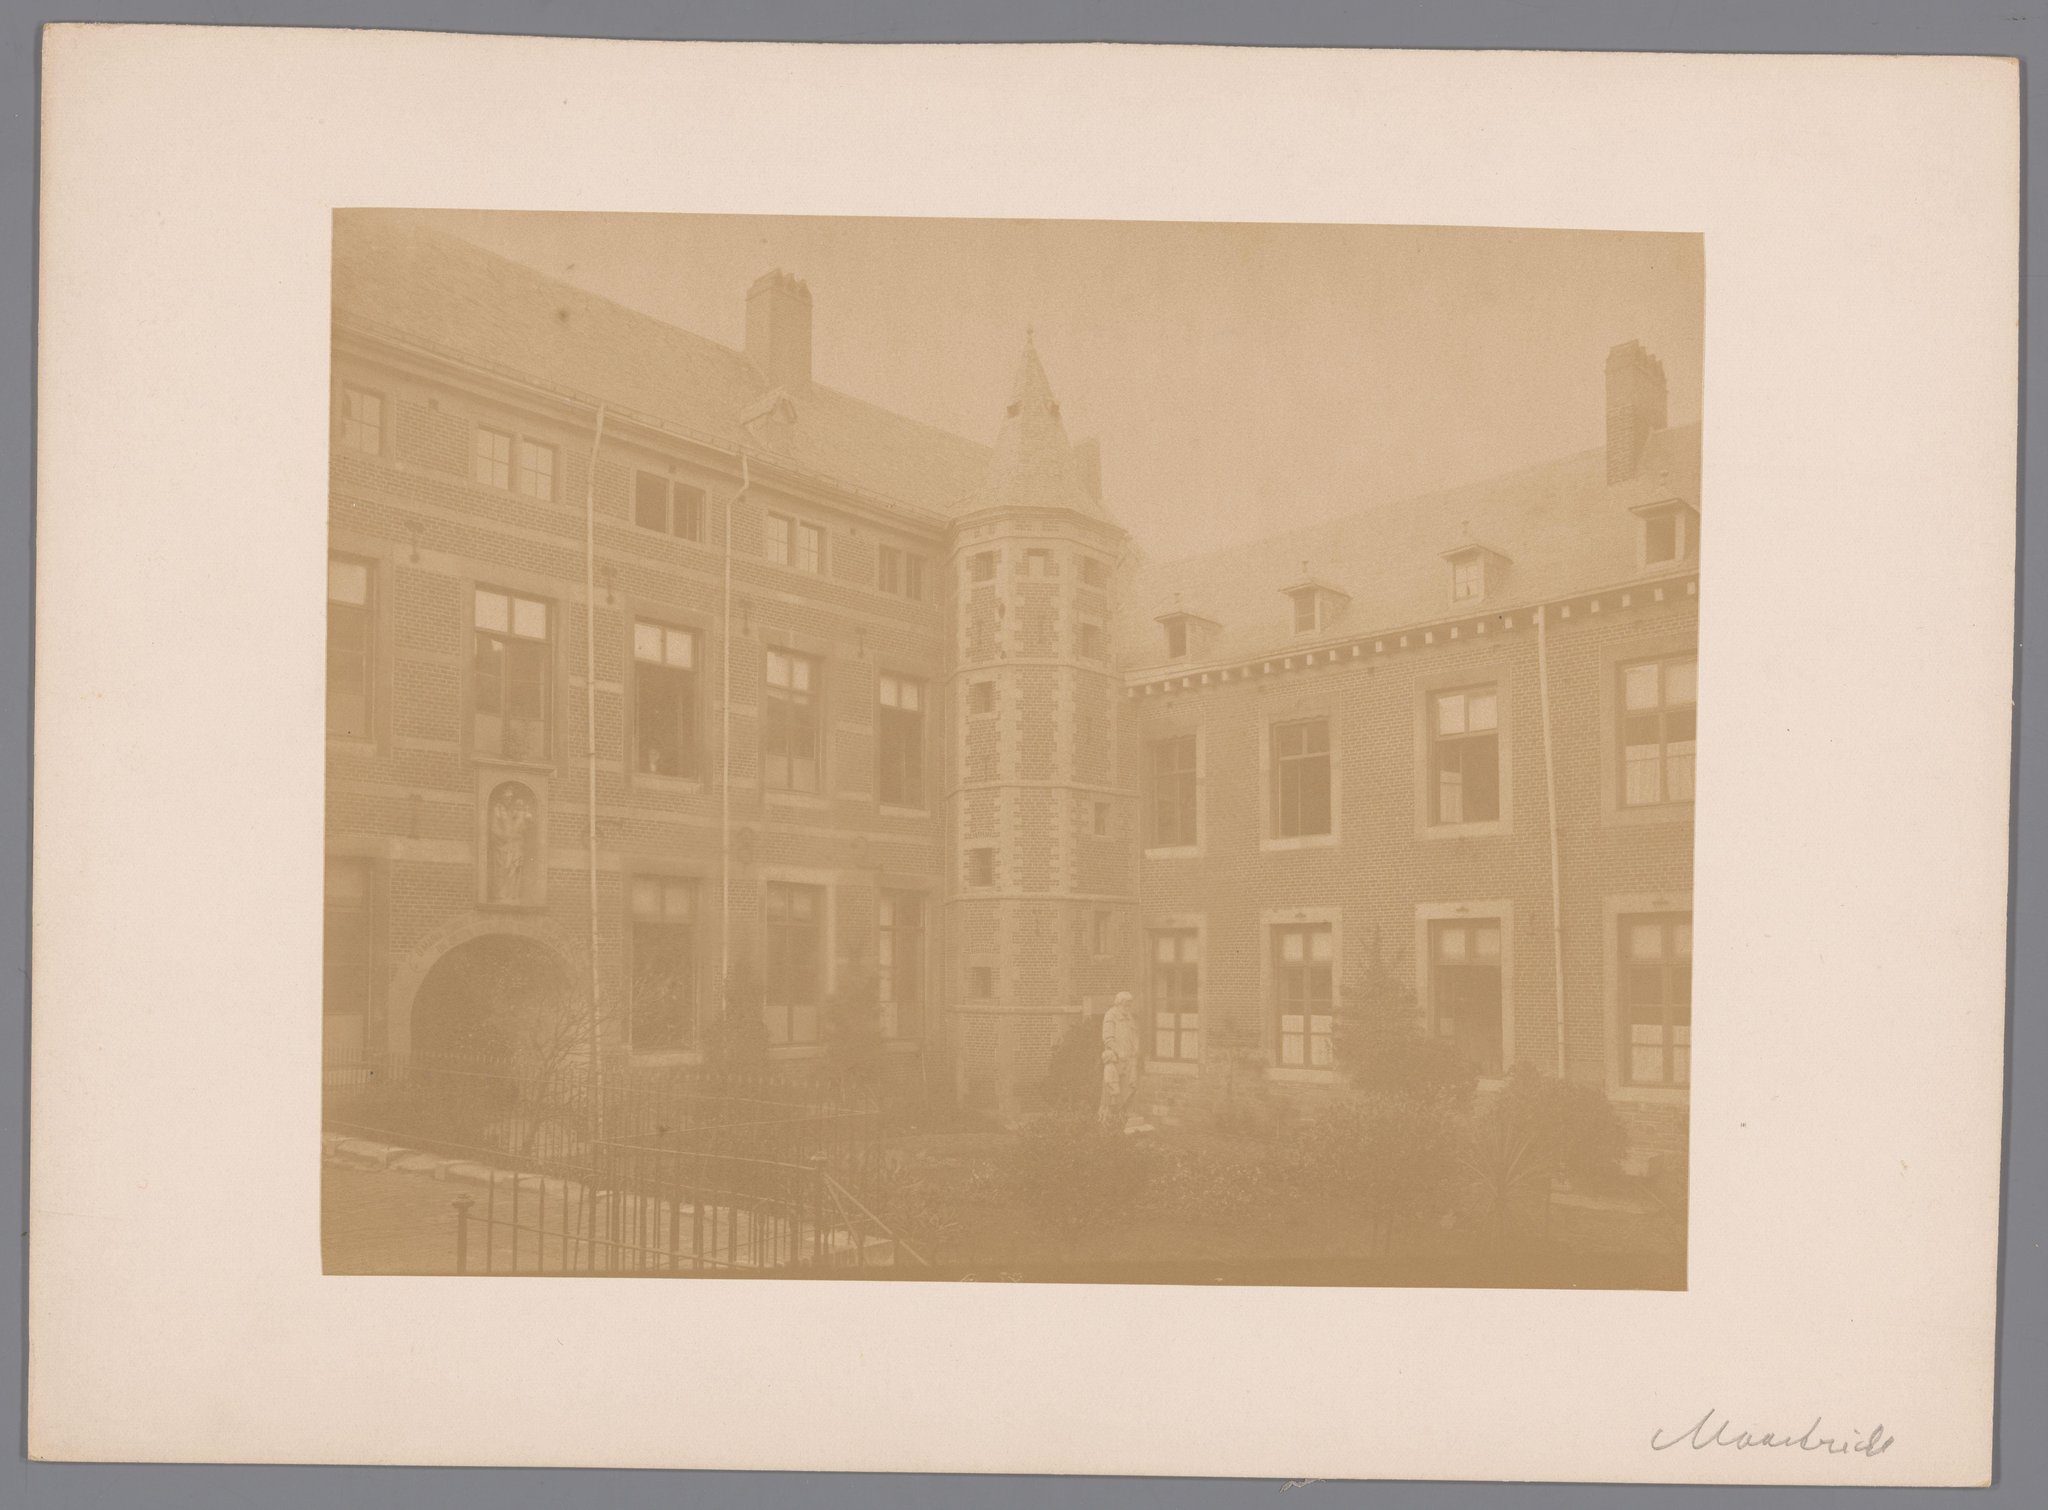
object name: photograph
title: Gezicht op de toren uit 1682 bij de Zusters onder de bogen te Maastricht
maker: anoniem (monumentenzorg)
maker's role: fotograaf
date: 1898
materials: cardboard, photographic support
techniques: albumen print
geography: maastricht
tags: abbey, monastery, convent ~ roman catholic church, parts of church exterior and annexes: tower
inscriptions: annotation: ‘Bouw van 1682 bij der Zusters onder de bogen te Maastricht (L.)/ oct 1898’, annotation: ‘Maastricht’